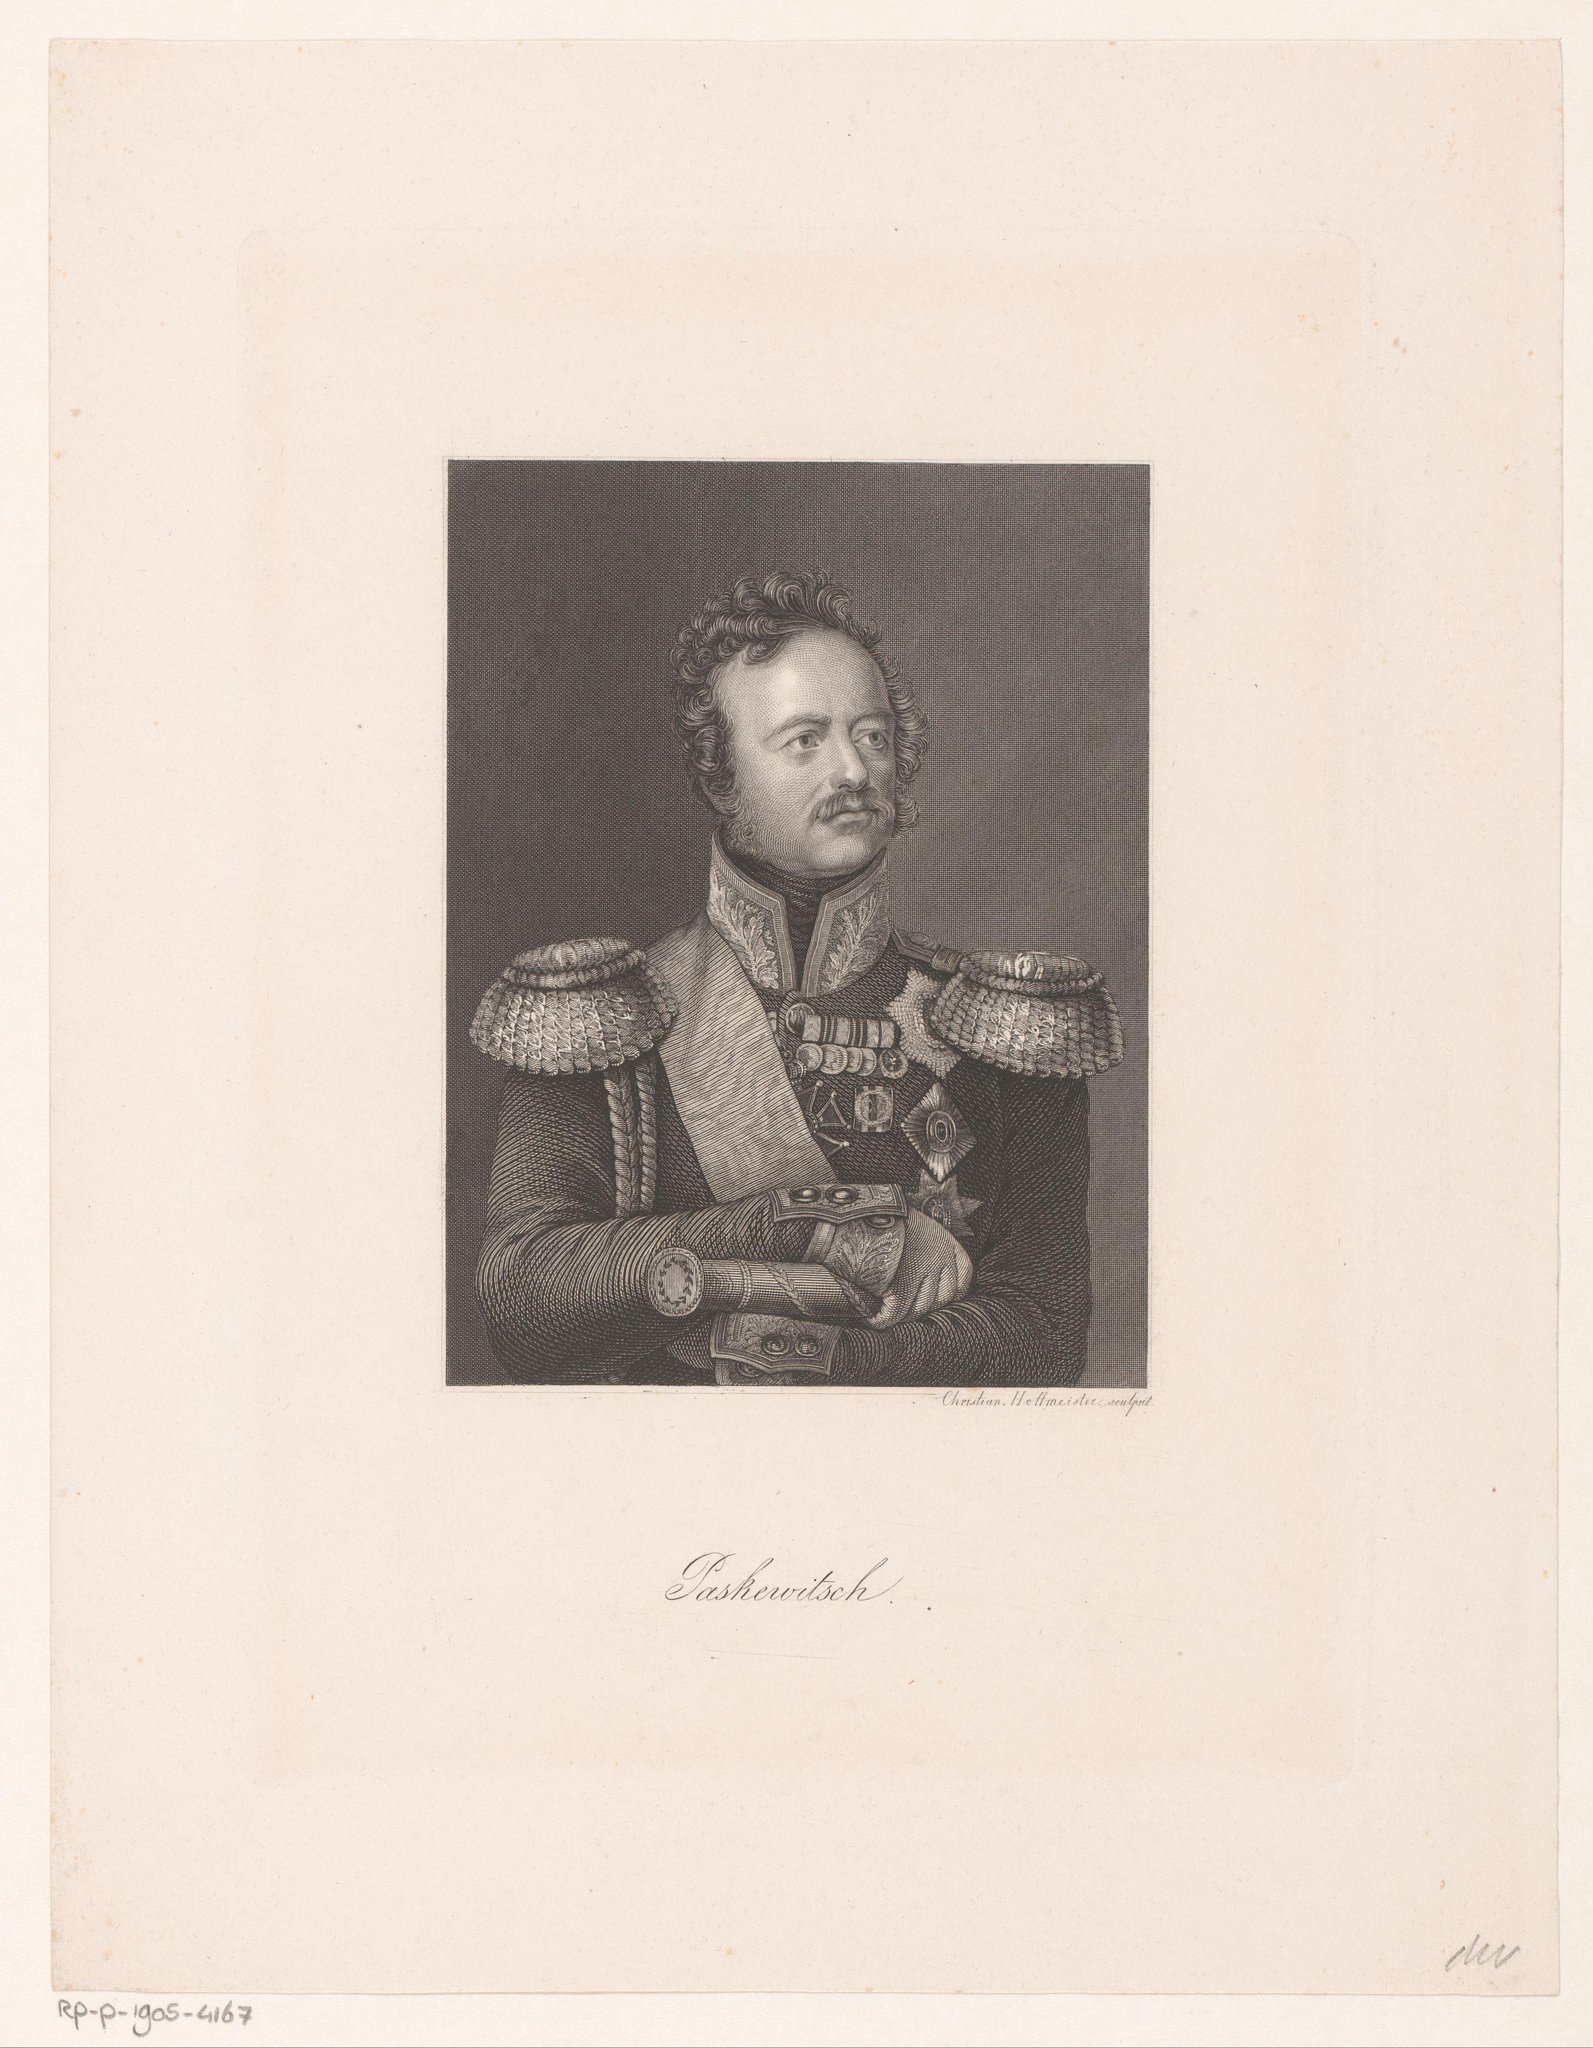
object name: print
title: Portret van Iwan Fjodorowitsch Paskewitsch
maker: christian hoffmeister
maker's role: print maker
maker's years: 1818-1871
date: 1828-1871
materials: paper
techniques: engraving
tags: politician, knighthood order, commander-in-chief, general, marshal, historical persons, medals and other marks of military honour, baton of general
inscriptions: collector's mark: Lugt 2228